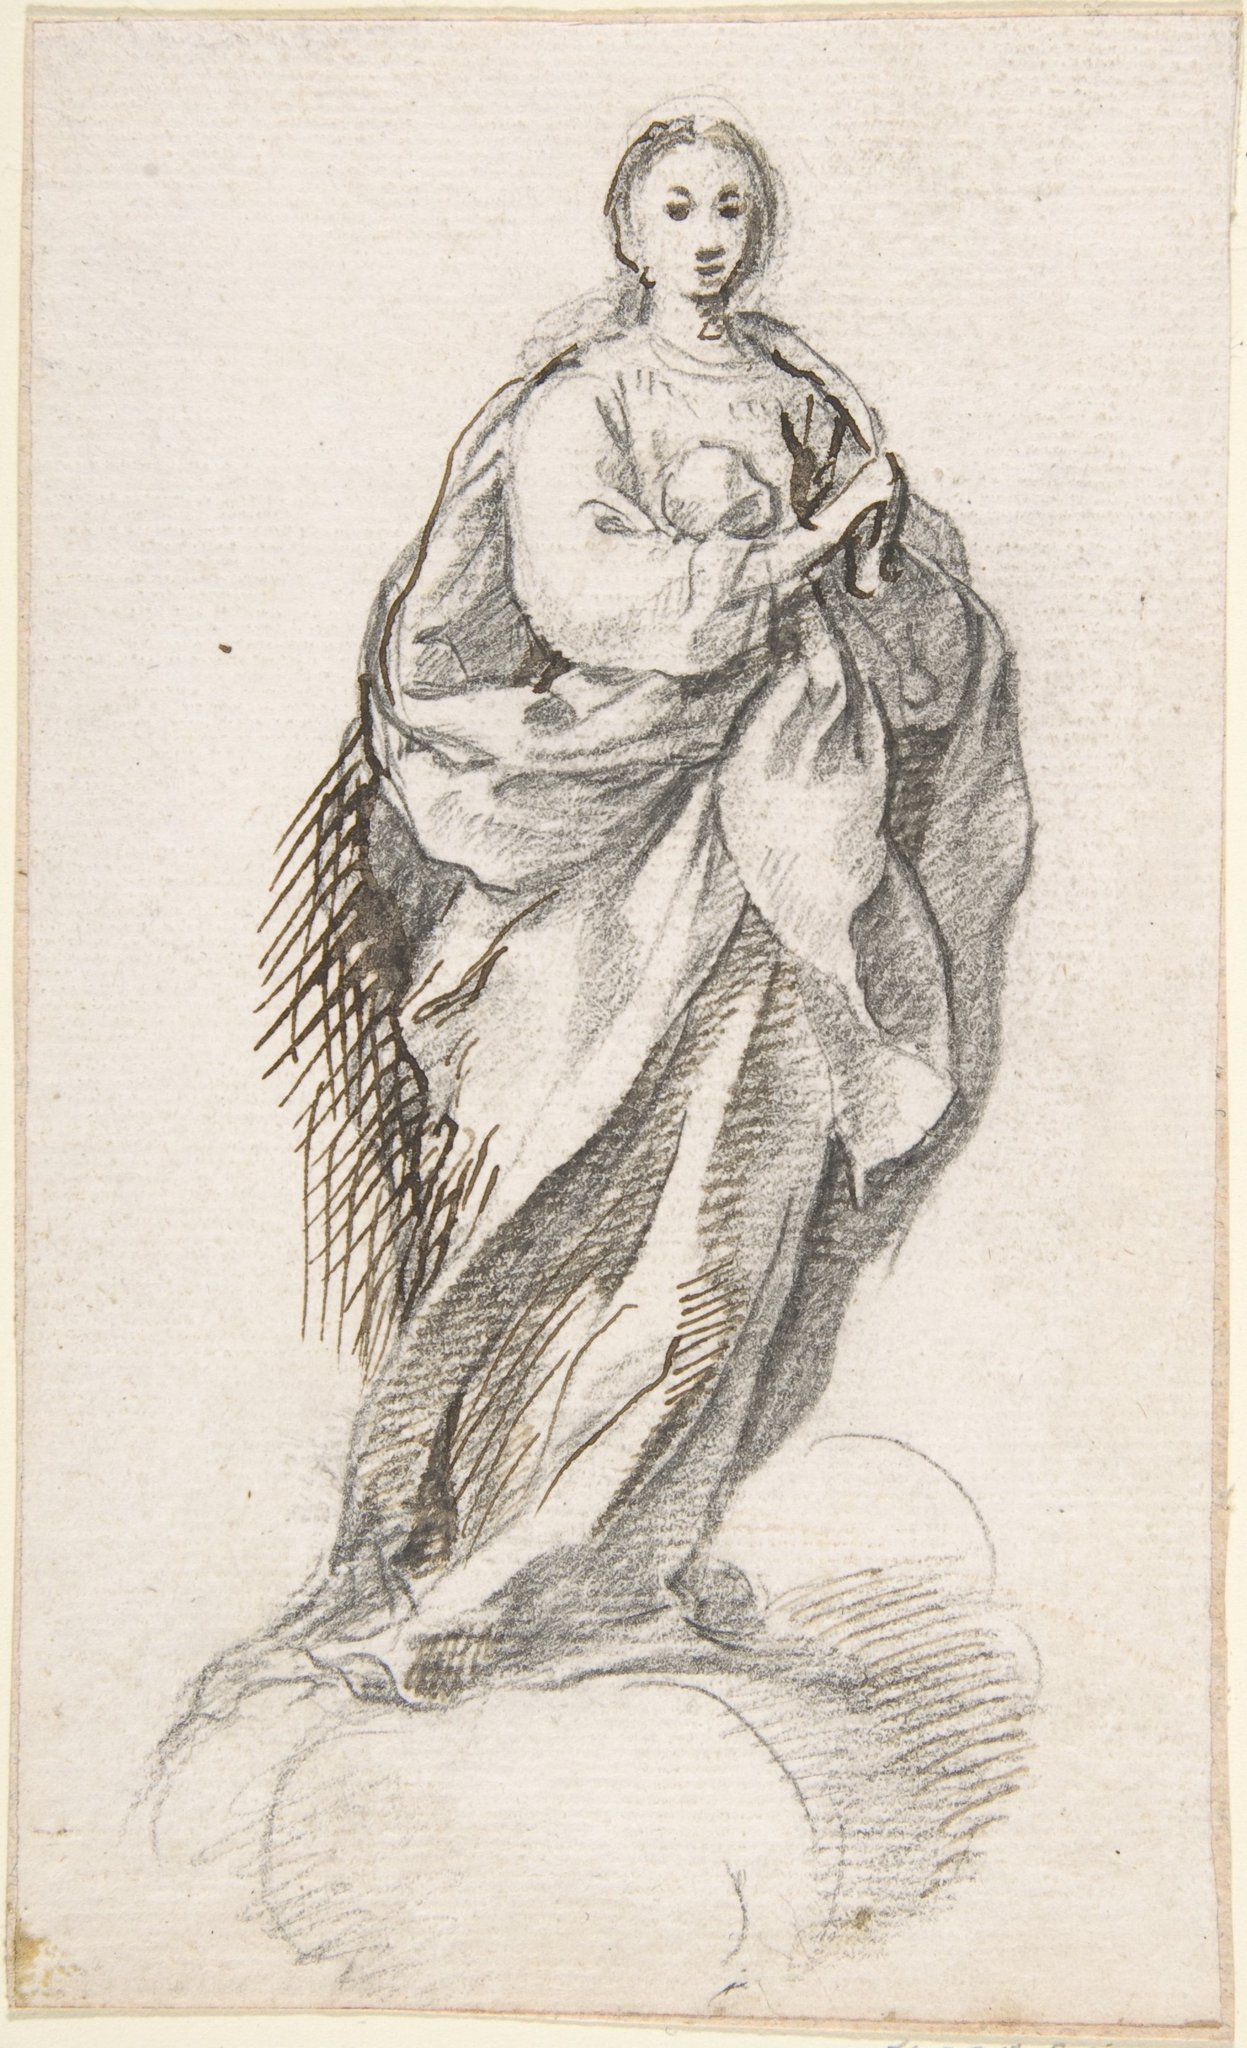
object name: drawing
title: Virgin of the Immaculate Conception Standing on Clouds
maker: pedro duque cornejo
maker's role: artist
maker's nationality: spanish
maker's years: 1677-1757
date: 1700-1750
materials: chalk, ink, paper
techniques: pen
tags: virgin mary